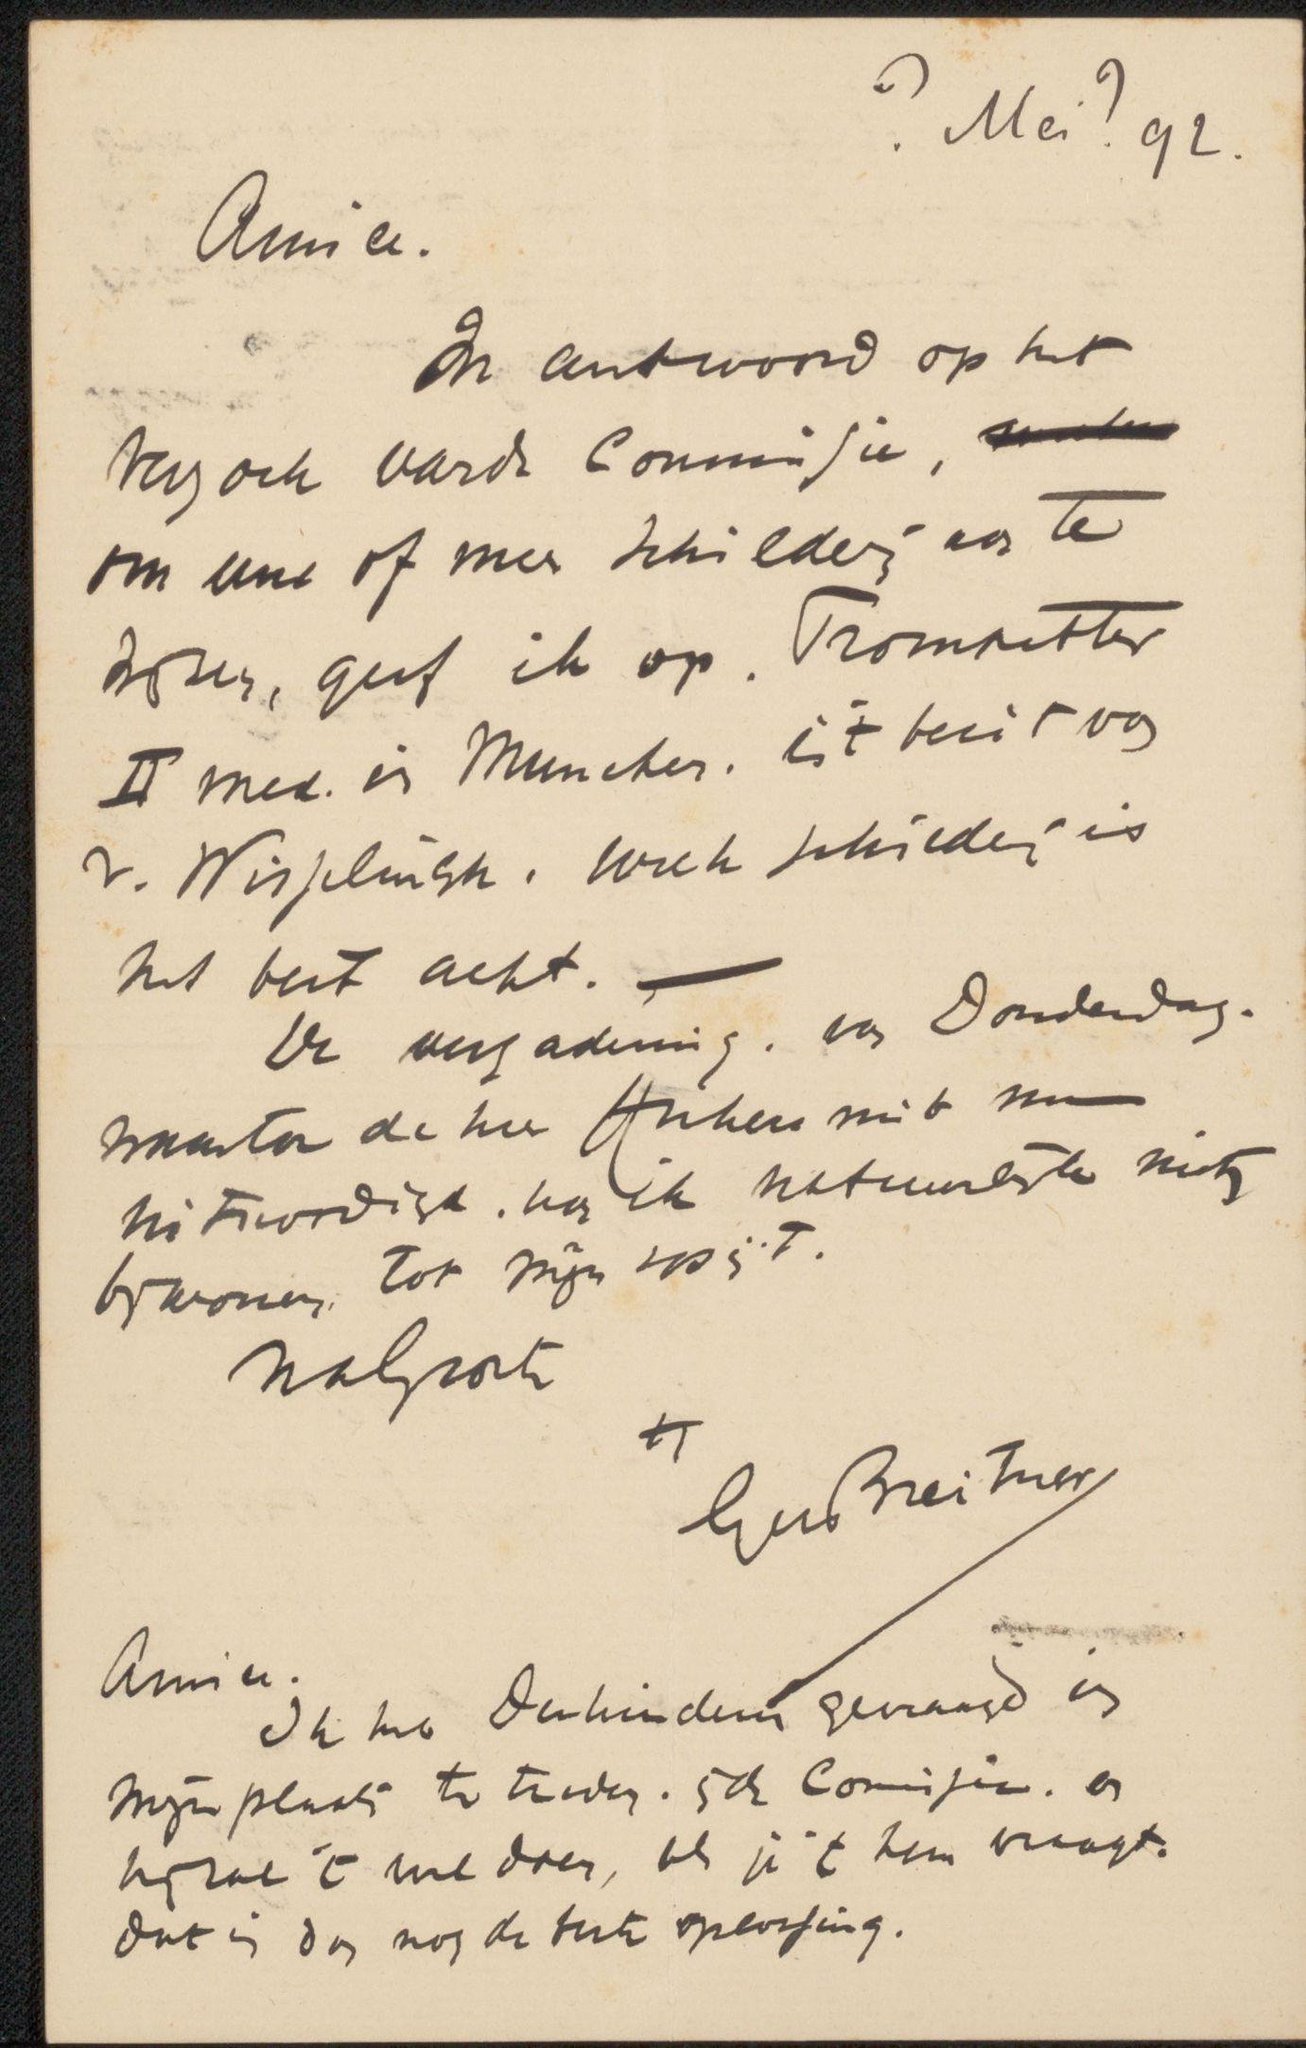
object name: letter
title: Brief aan Jan Veth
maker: george hendrik breitner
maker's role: draughtsman, painter, print maker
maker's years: 1857-1923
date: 1892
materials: ink, paper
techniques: pen, writing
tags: jan veth, den bosch, amsterdam, painter, print maker, draughtsman, antoon derkinderen, painting (including book-illumination, miniature-painting)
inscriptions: collector's mark: ‘RPK’